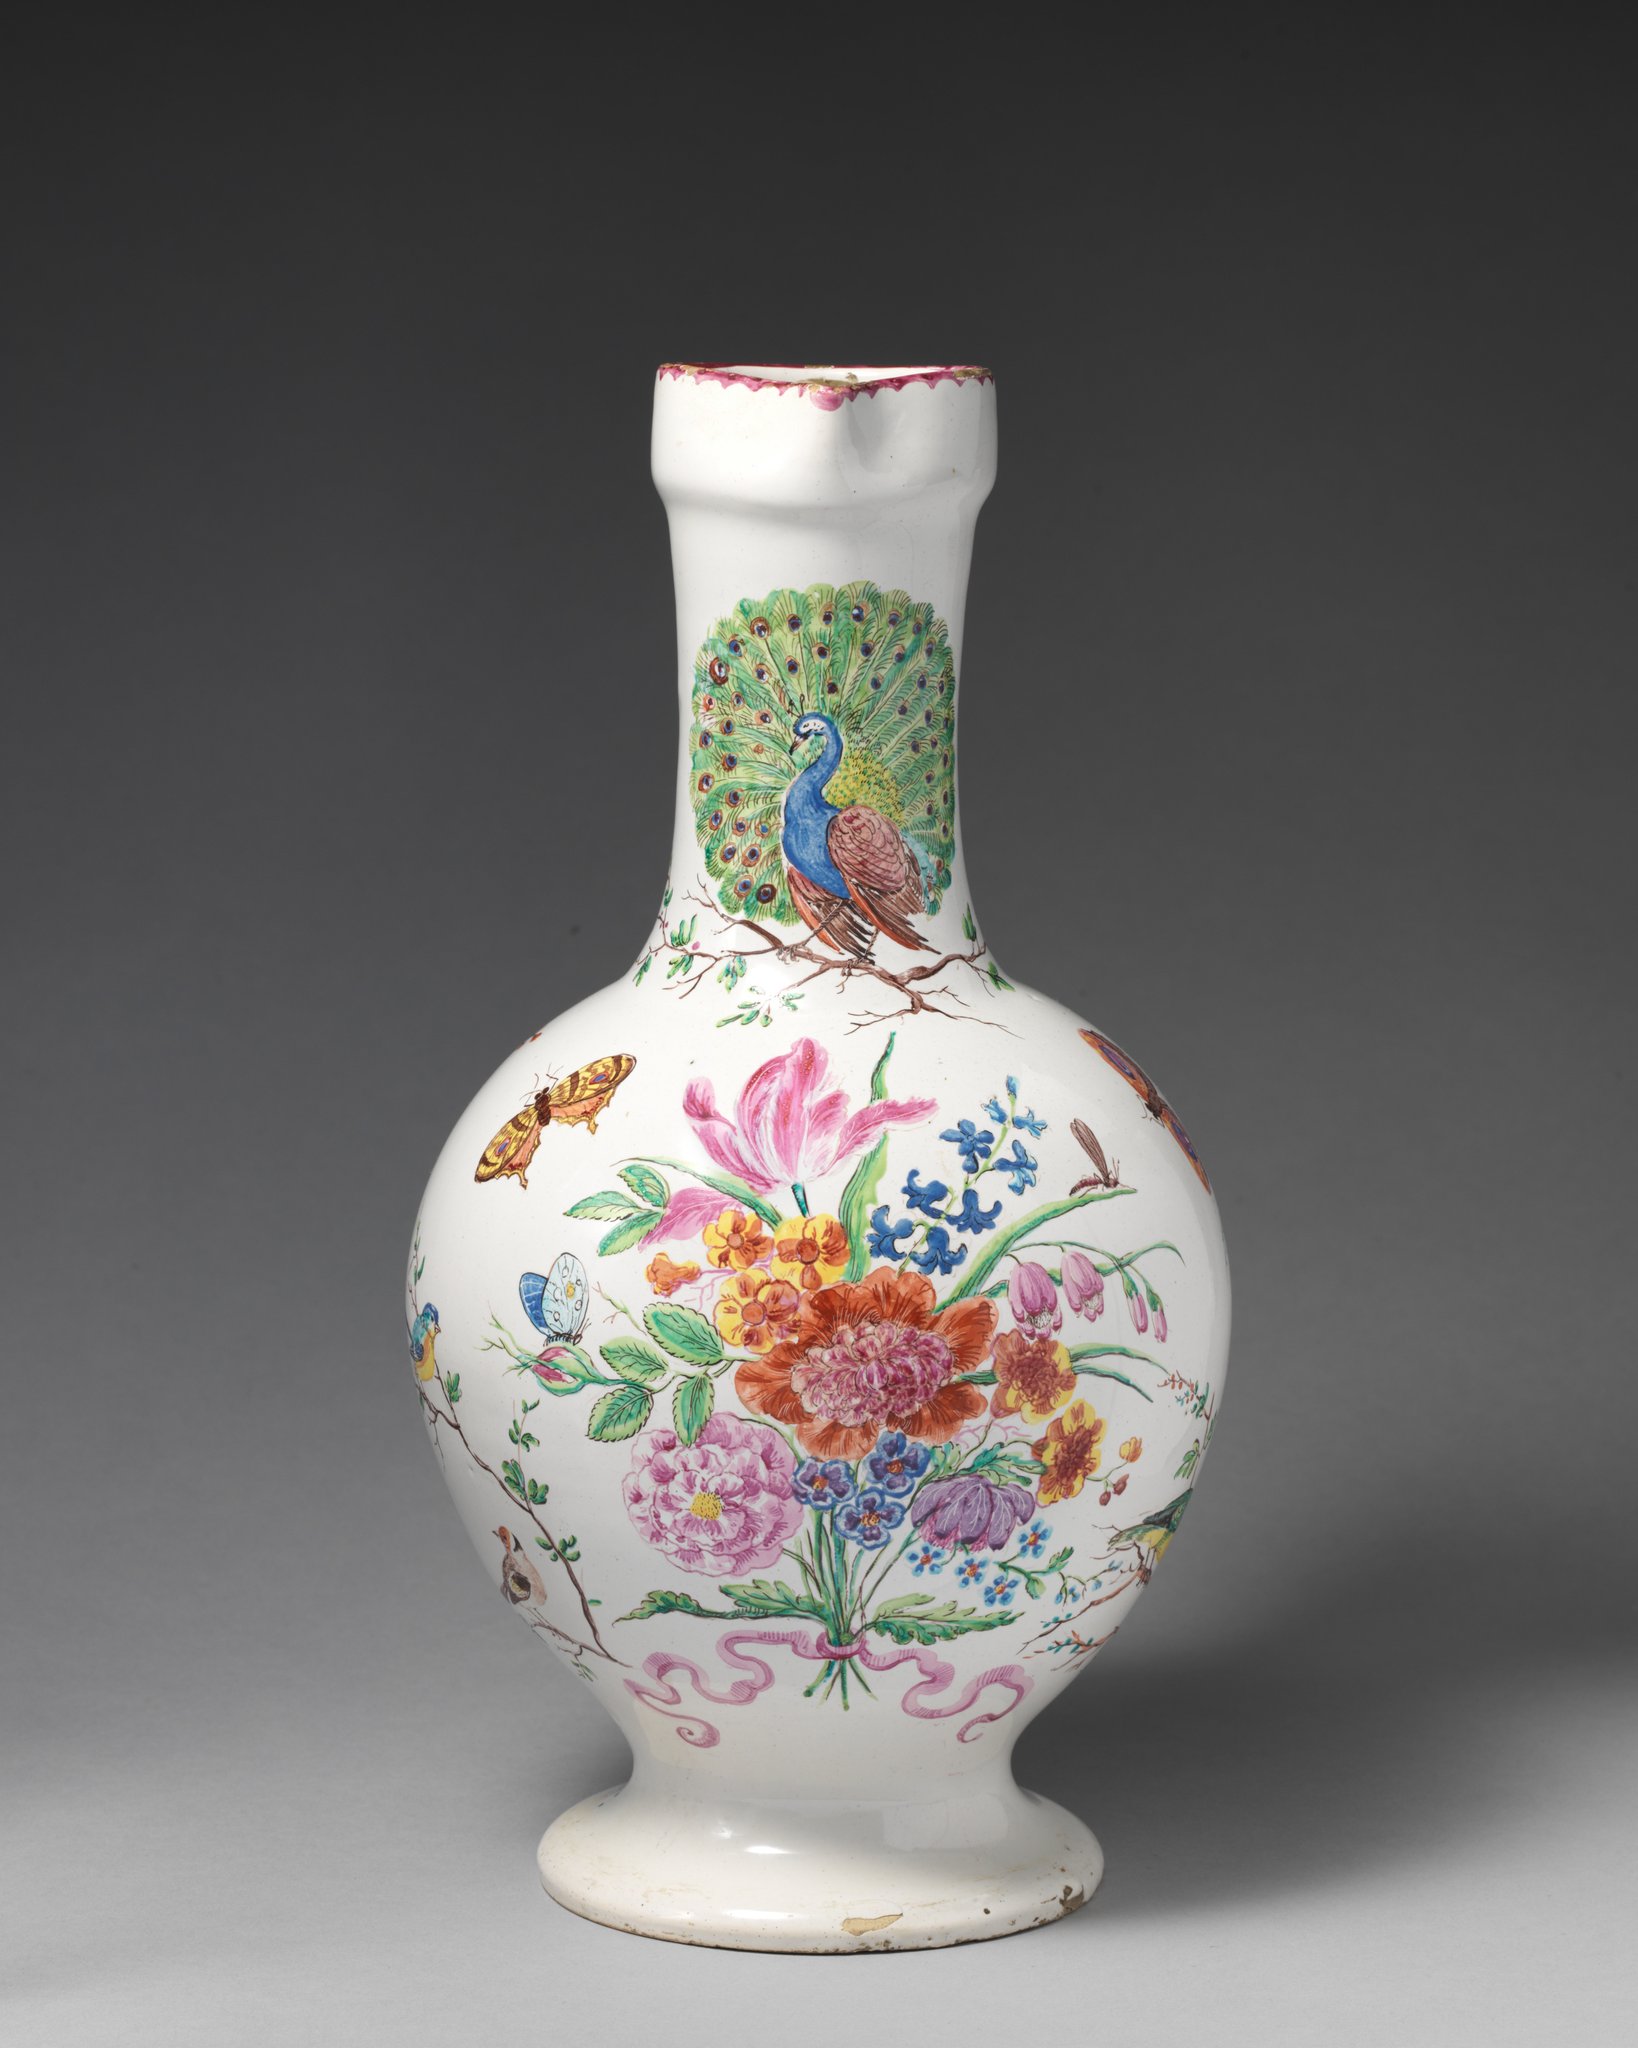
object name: jug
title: Jug with flowers and peacock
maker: bartholomäus seuter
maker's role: decorator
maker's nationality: german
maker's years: 1678-1754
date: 1720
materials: earthenware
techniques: glazing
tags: peacocks,butterflies,flowers